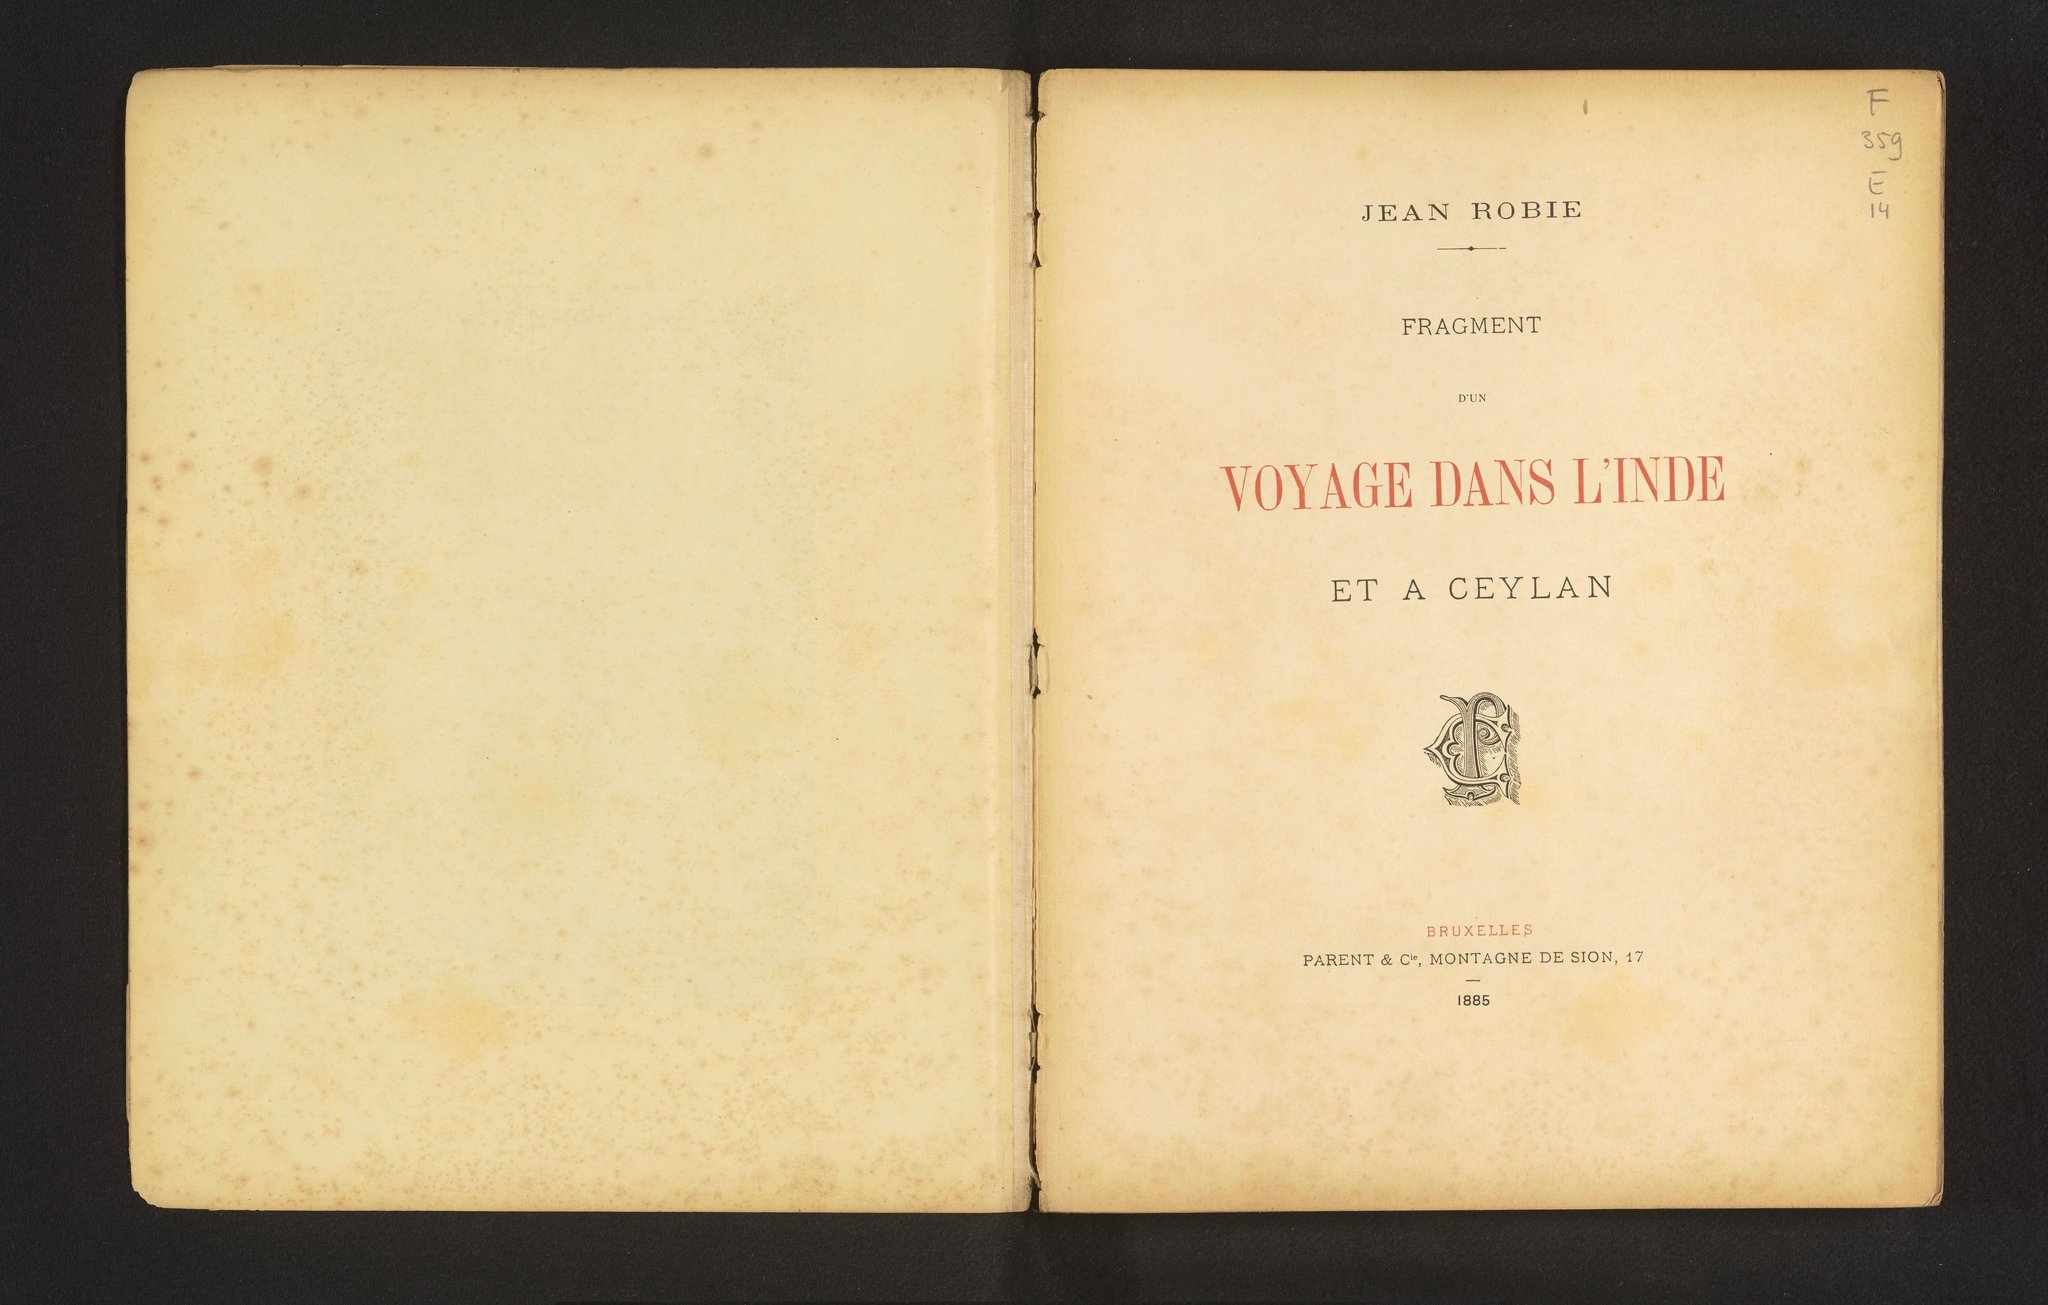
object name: book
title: Fragment d'un voyage dans l'Inde et à Ceylan / Jean Robie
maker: jean baptiste robie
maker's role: painter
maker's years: 1821-1910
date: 1885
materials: cardboard, paper, photographic support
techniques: albumen print, printing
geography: brussels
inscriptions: annotation: ‘OCT 1982’, bookplate: ‘EX/ SFJ/ LIBRIS’, annotation: ‘F./ 2e partie seule./ 10 photographies H.T.’